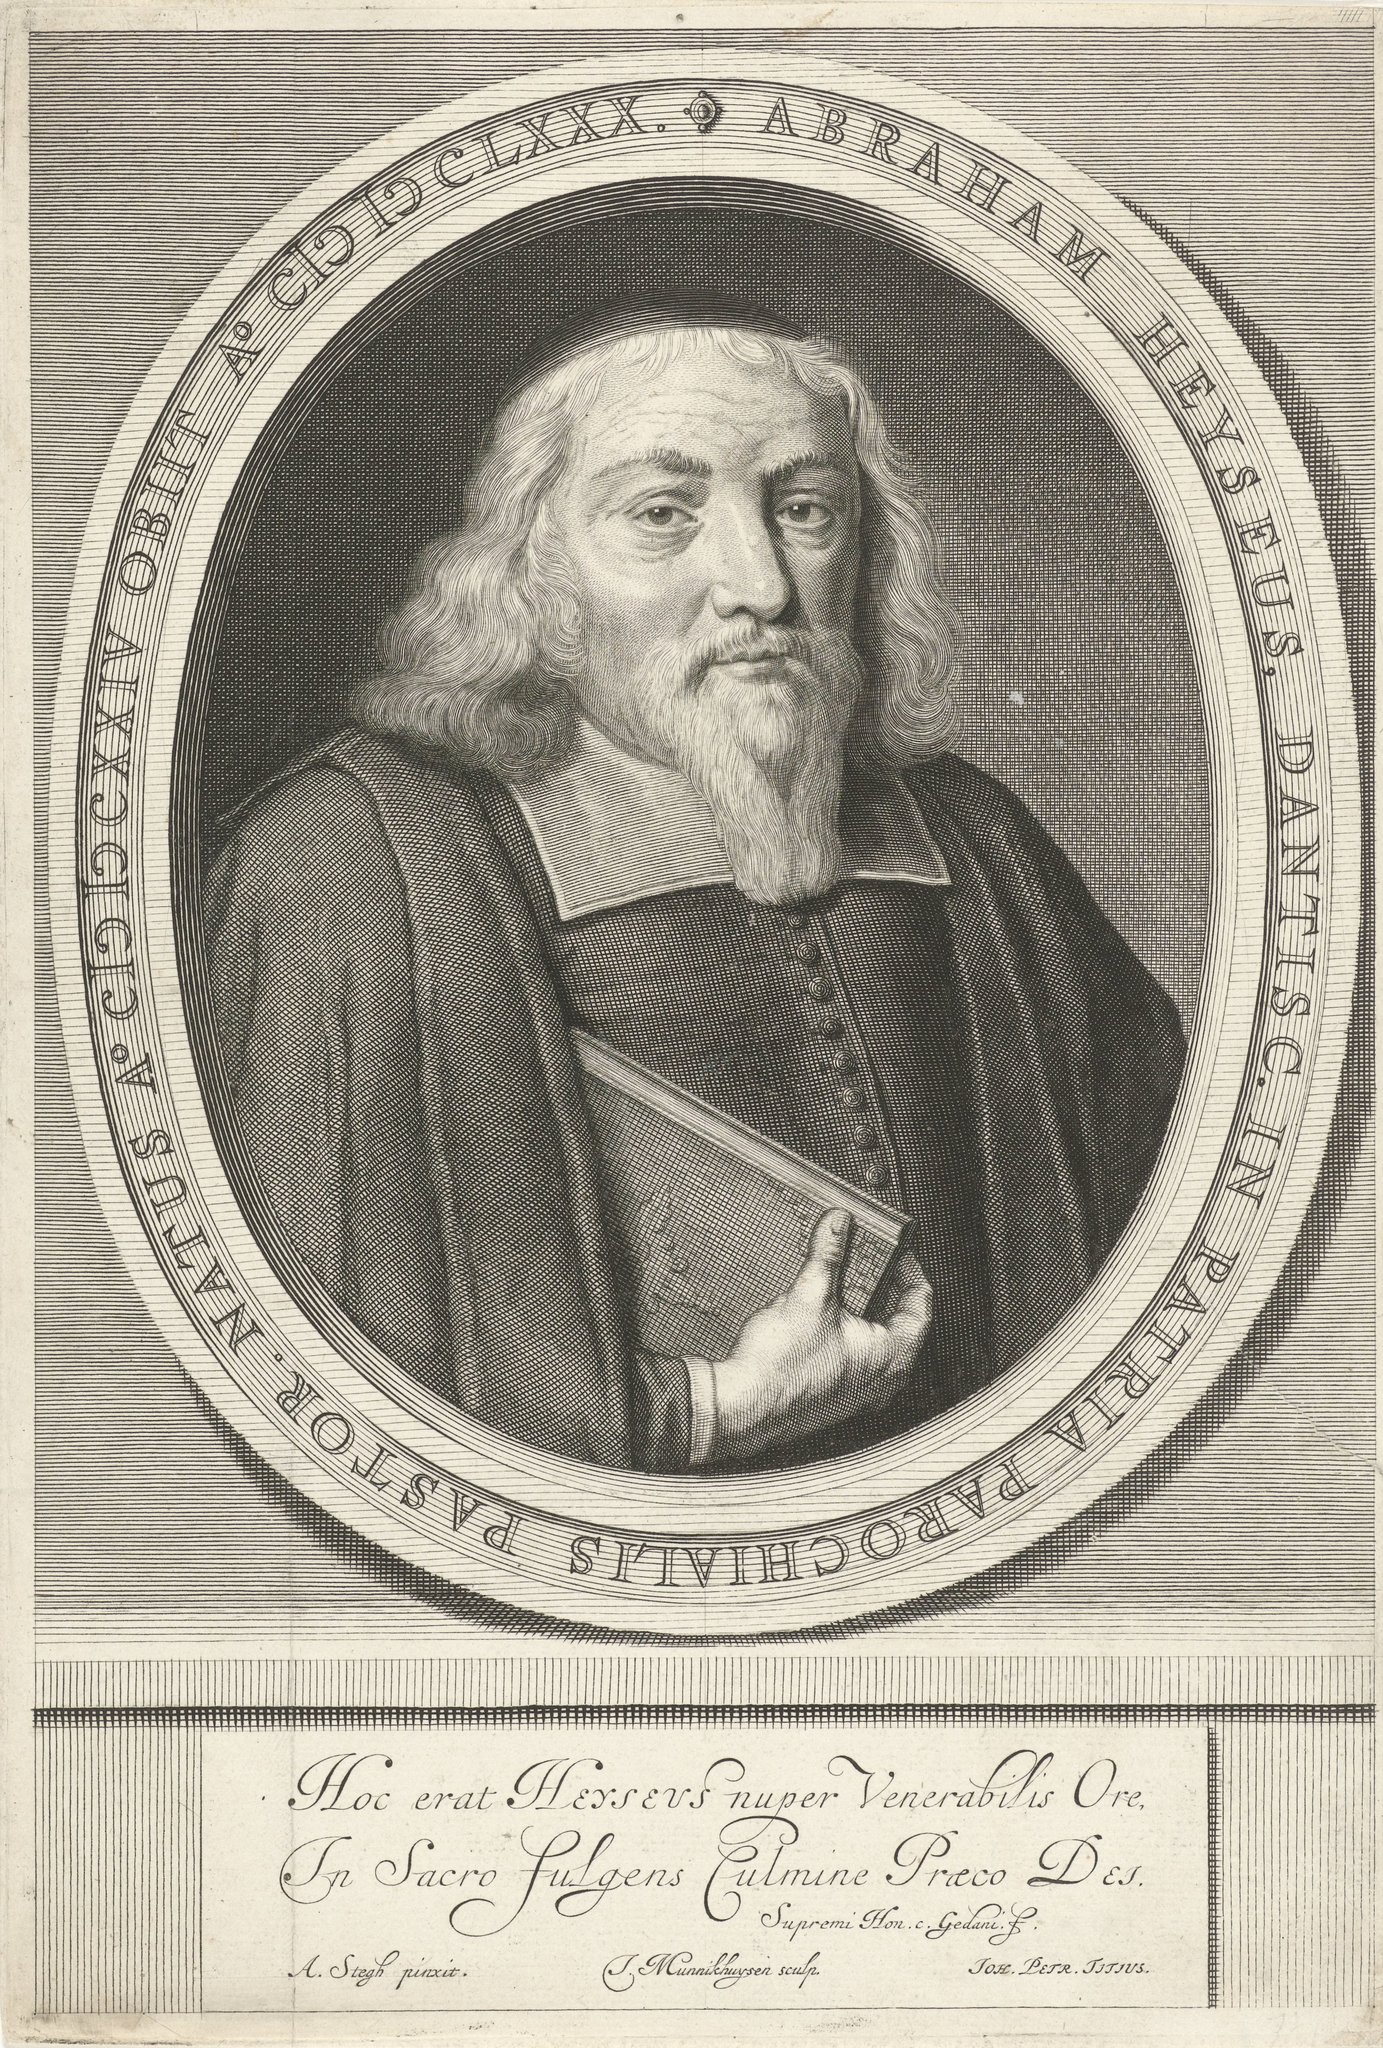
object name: print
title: Portret van Abraham Heyse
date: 1685-1721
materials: paper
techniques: engraving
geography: netherlands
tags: abraham heyse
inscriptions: collector's mark: Lugt 2228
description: Portret van Abraham Heyse, predikant te Danzig, met een Bijbel onder de arm. Onderaan in de marge twee verzen in het Latijn.